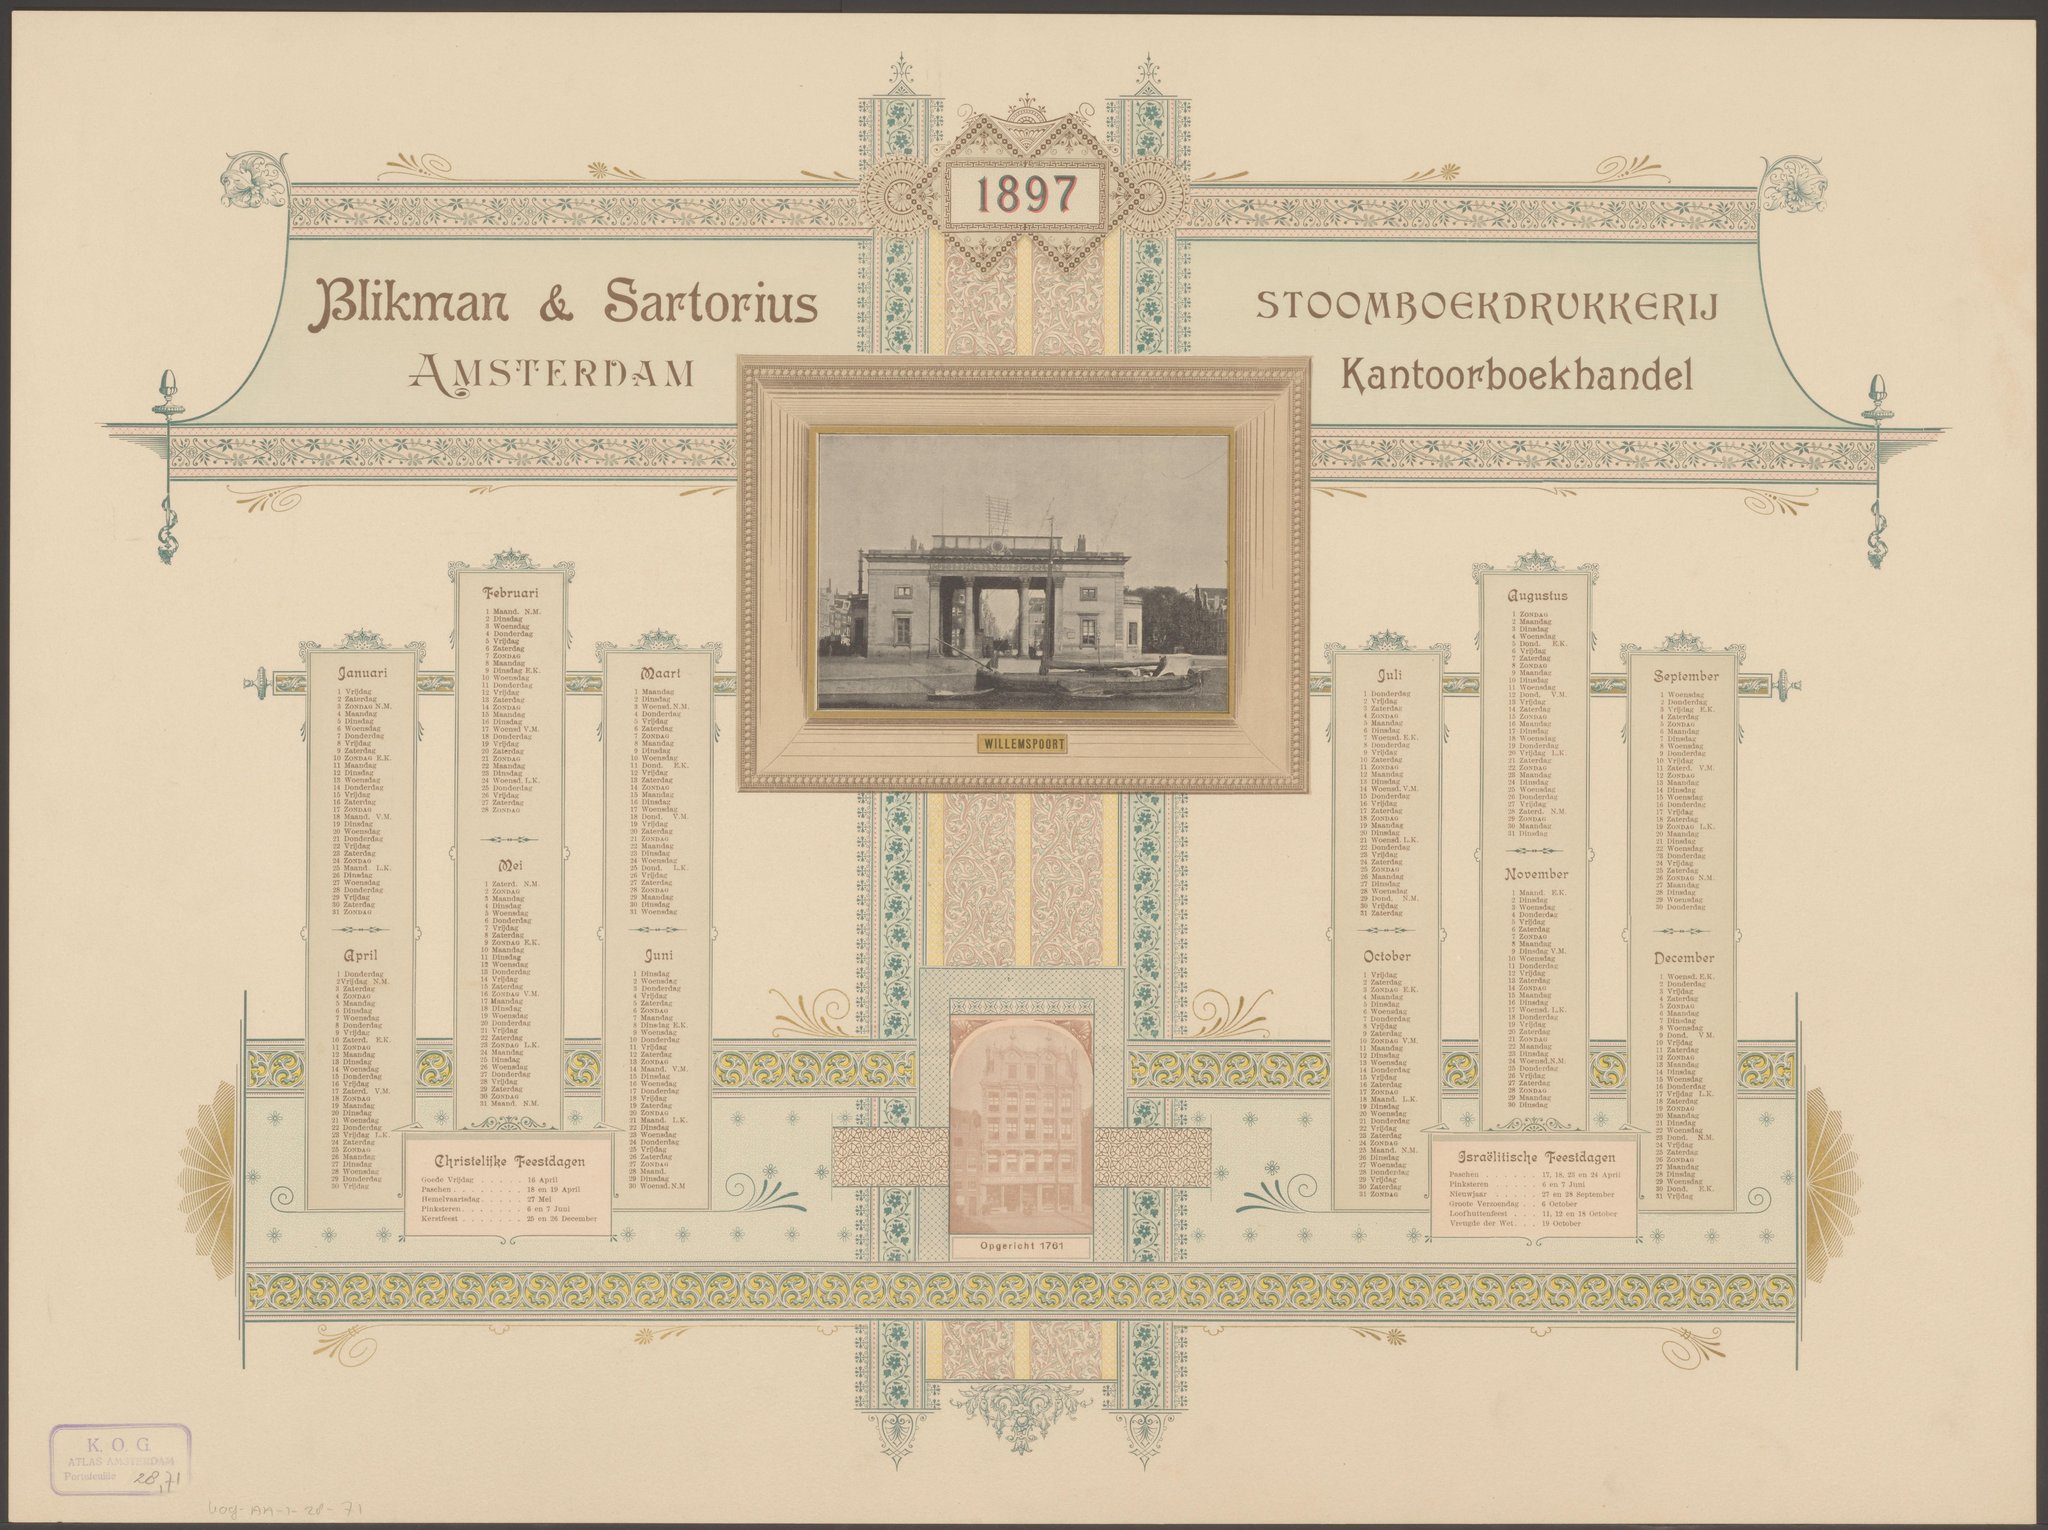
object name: photomechanical print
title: Kalender met een gezicht op de Willemspoort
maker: Anonymous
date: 1897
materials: paint, paper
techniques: line block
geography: amsterdam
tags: calendar, almanac, city-gate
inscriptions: collector's mark: Lugt 1641b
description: Kalender van de stoomboekdrukkerij en kantoorboekhandel Blikman & Sartorius te Amsterddam. In het midden een gezicht op de Willemspoort. Onderwerpsrubriek binnen de Atlas Amsterdam: Poorten, verzamelbladen, F. Willemspoort.